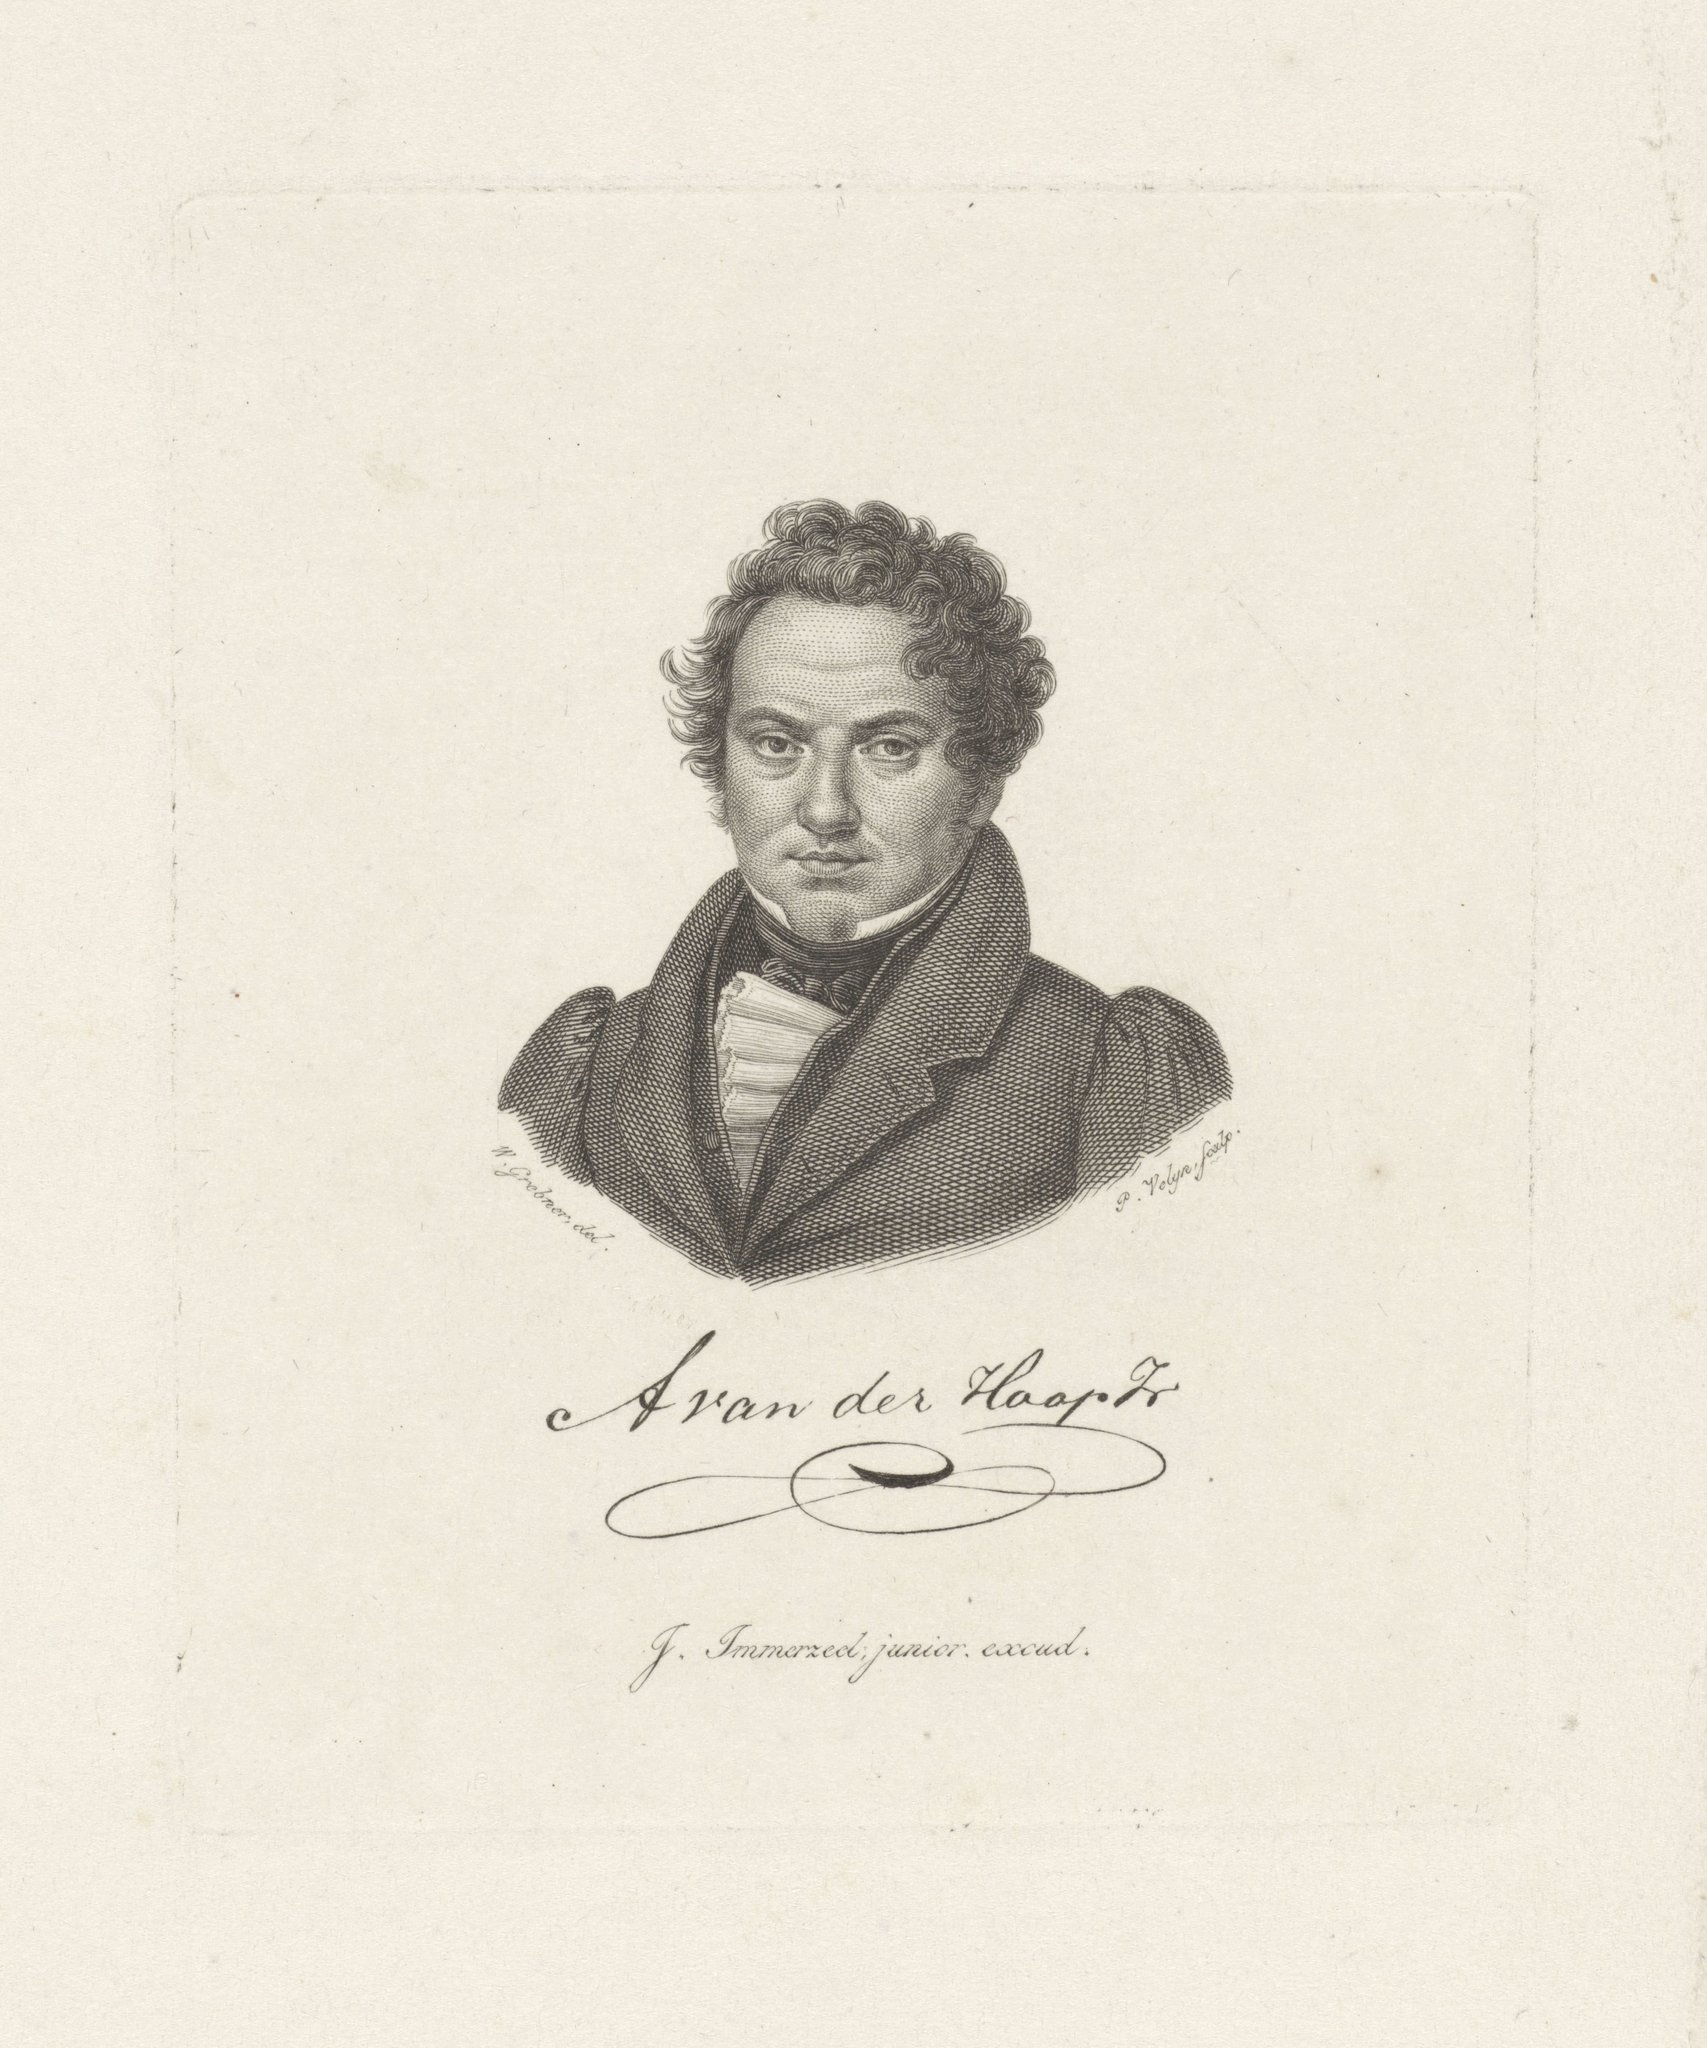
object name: print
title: Portret van Adriaan van der Hoop Jr'sz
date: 1832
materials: paper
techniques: engraving, etching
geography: netherlands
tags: adriaan van der hoop juniorsz.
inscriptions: collector's mark: Lugt 240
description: Volgens Van Someren prent ook gebruikt in: Nederlandsche Muzen-Almanak. Rotterdam: J. Immerzeel, 1832.